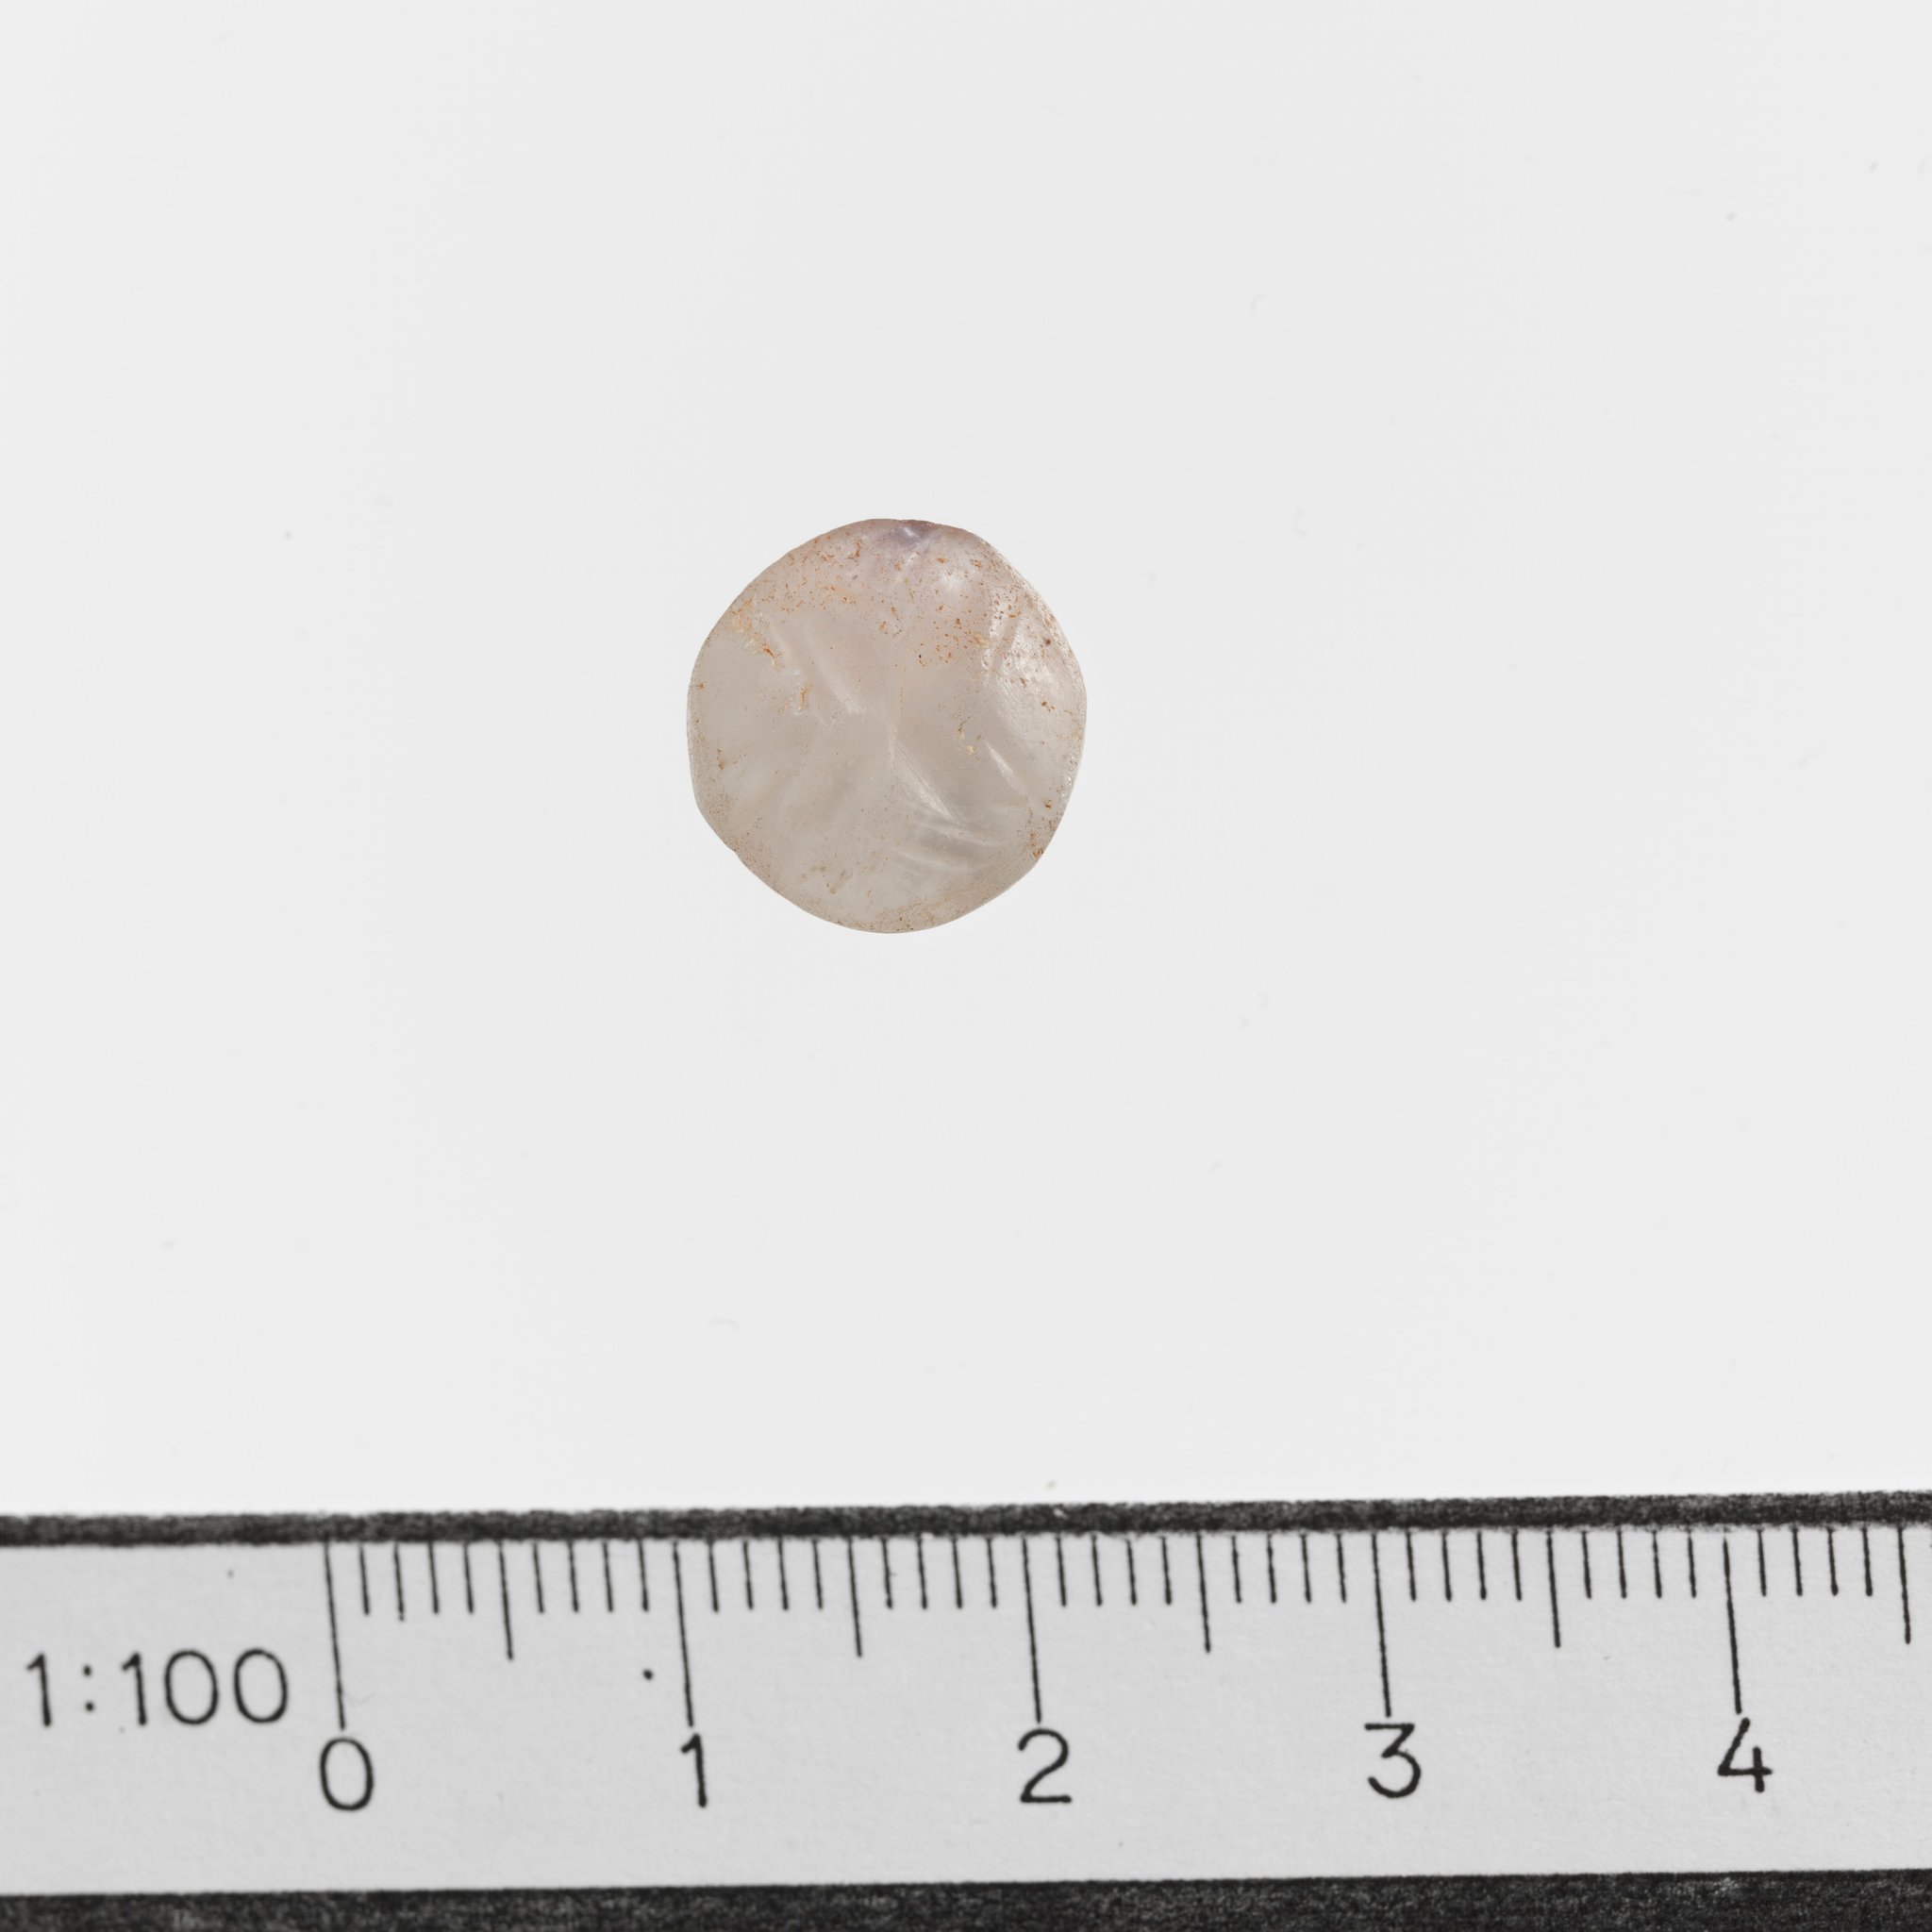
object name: seal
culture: minoan, crete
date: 2000-1450 BCE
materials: quartz